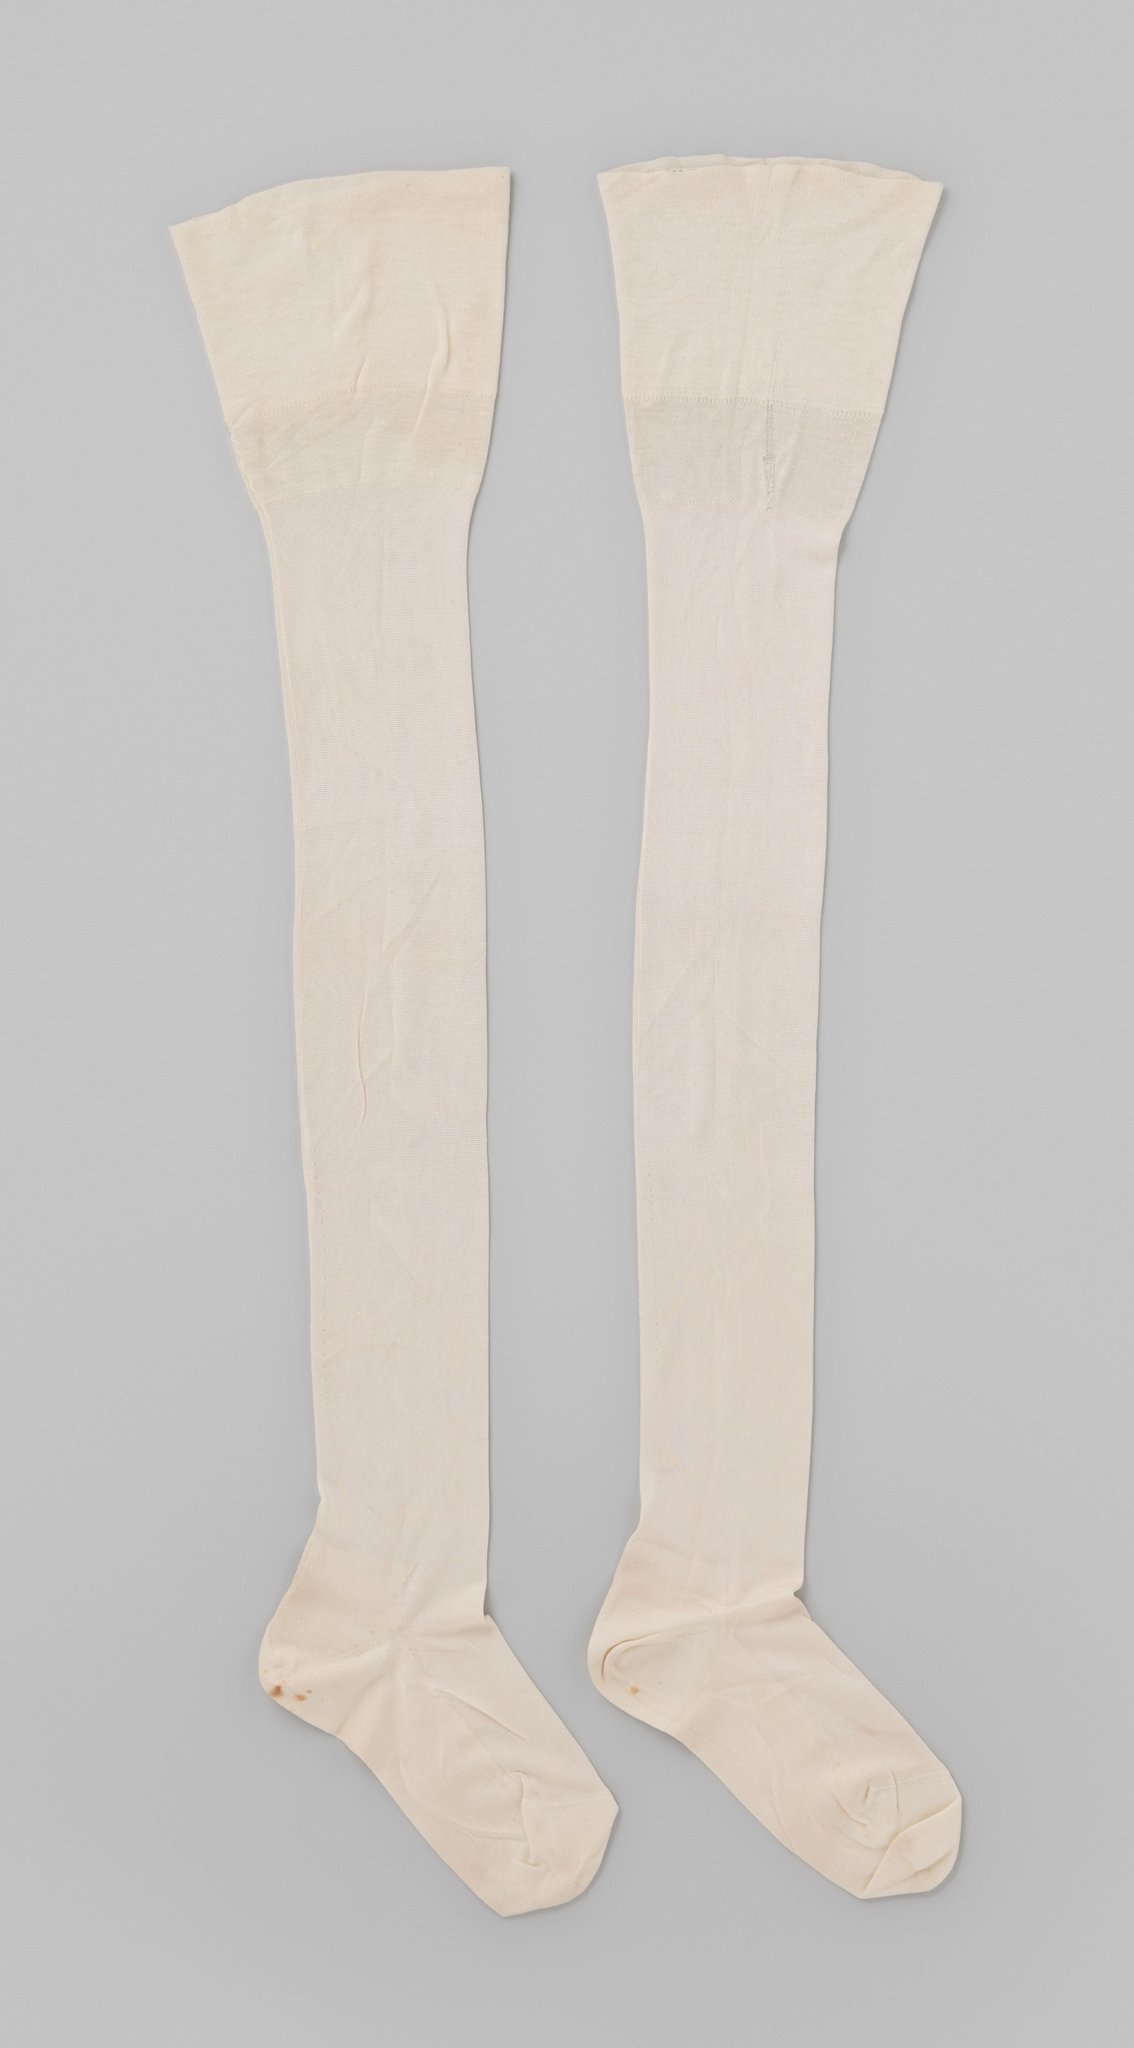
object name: clothing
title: Kous gebreid van witte zijde met brede katoenen boord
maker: Anonymous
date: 1910-1920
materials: cotton, silk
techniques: knitting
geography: lille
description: Kous van witte zijde. Model: met naad. Boord van katoen. Vierkante hiel. Bruine vlekken op de hiel.